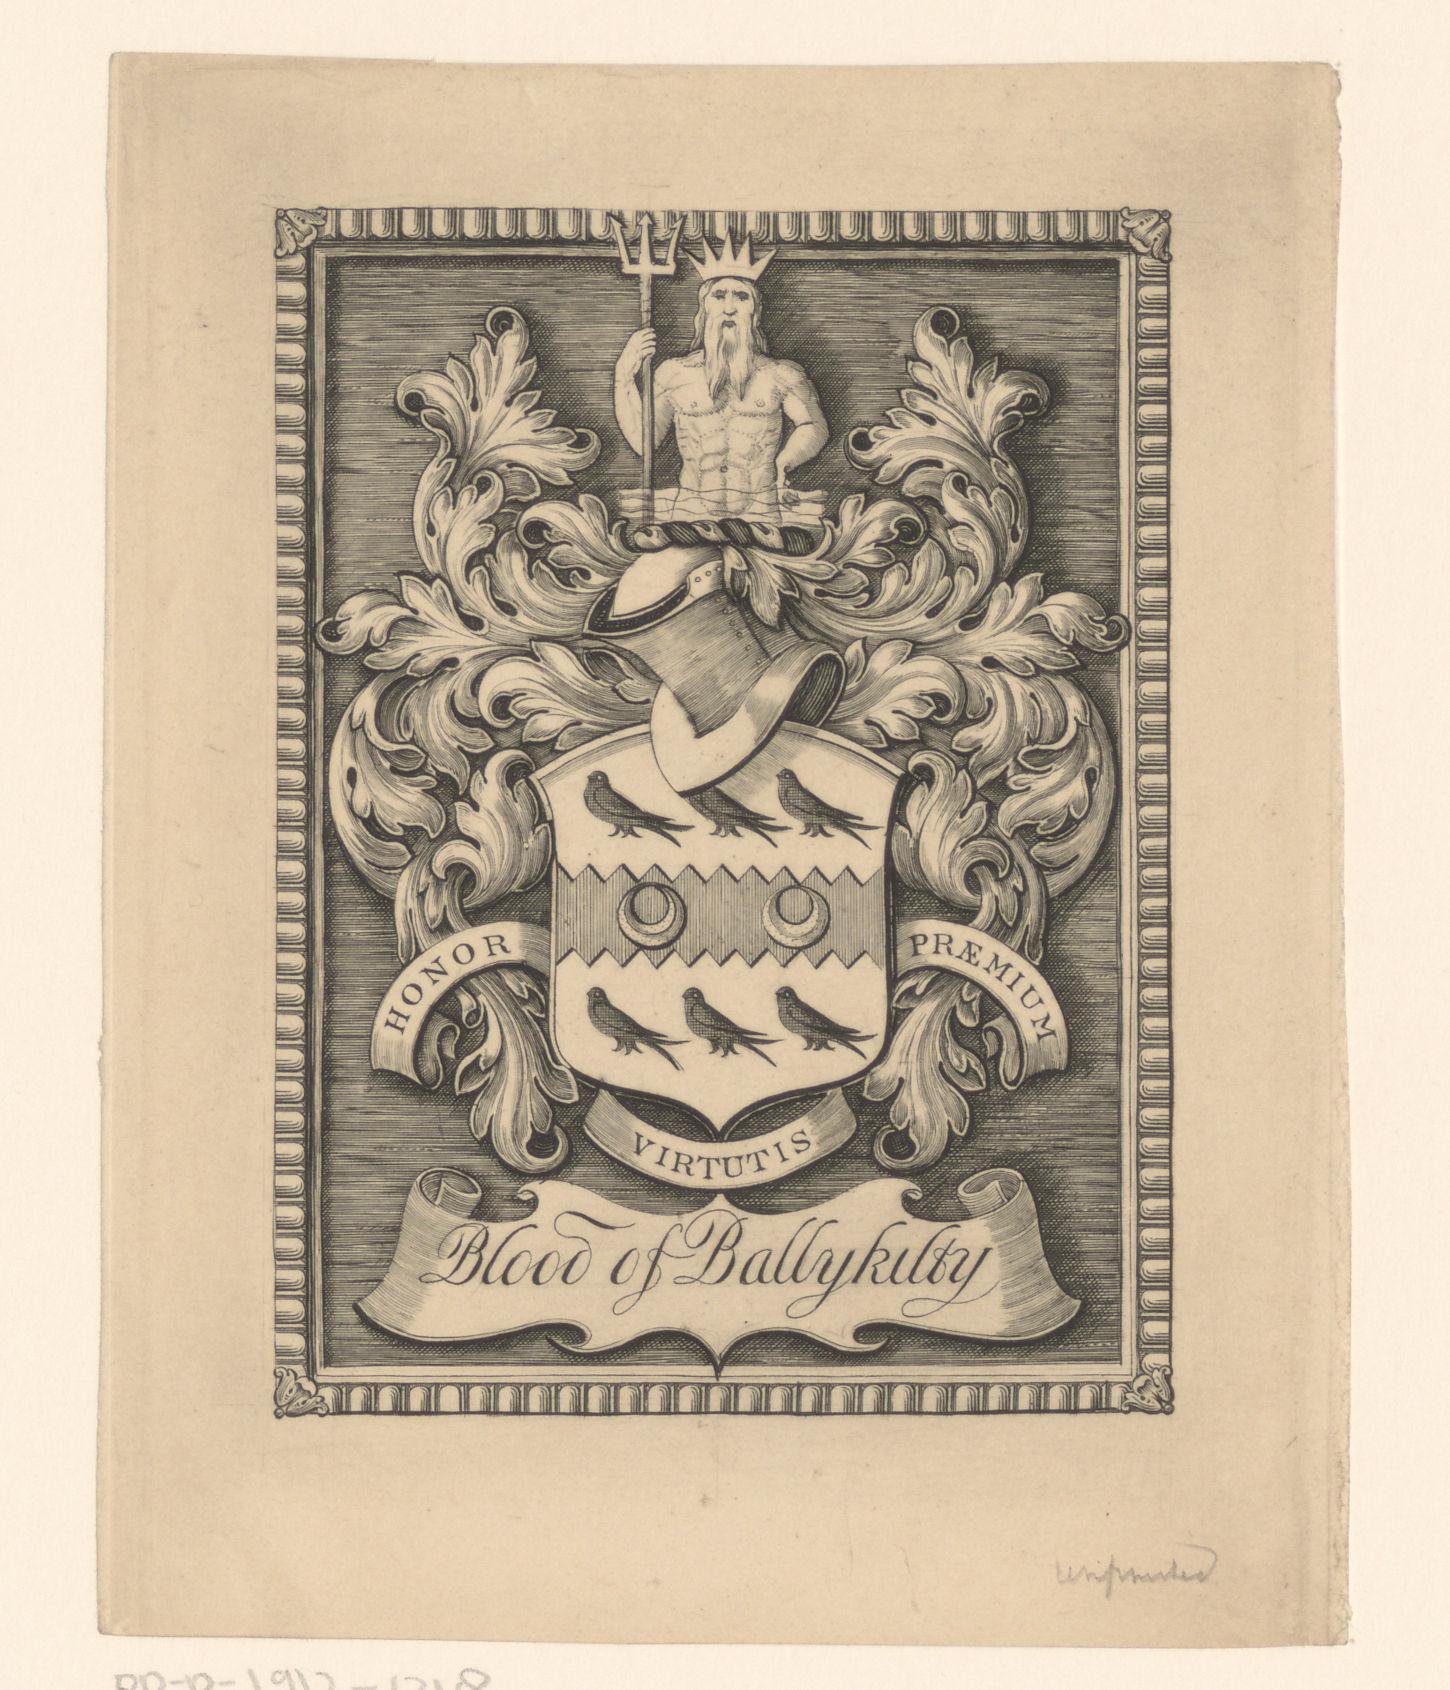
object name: bookplate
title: Honor praemium virtutis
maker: charles william sherborn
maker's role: print maker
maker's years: 1831-1912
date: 1841-1912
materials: paper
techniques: engraving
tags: (story of) neptune (poseidon), foliage ~ ornament, armorial bearing, heraldry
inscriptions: collector's mark: Lugt 2228